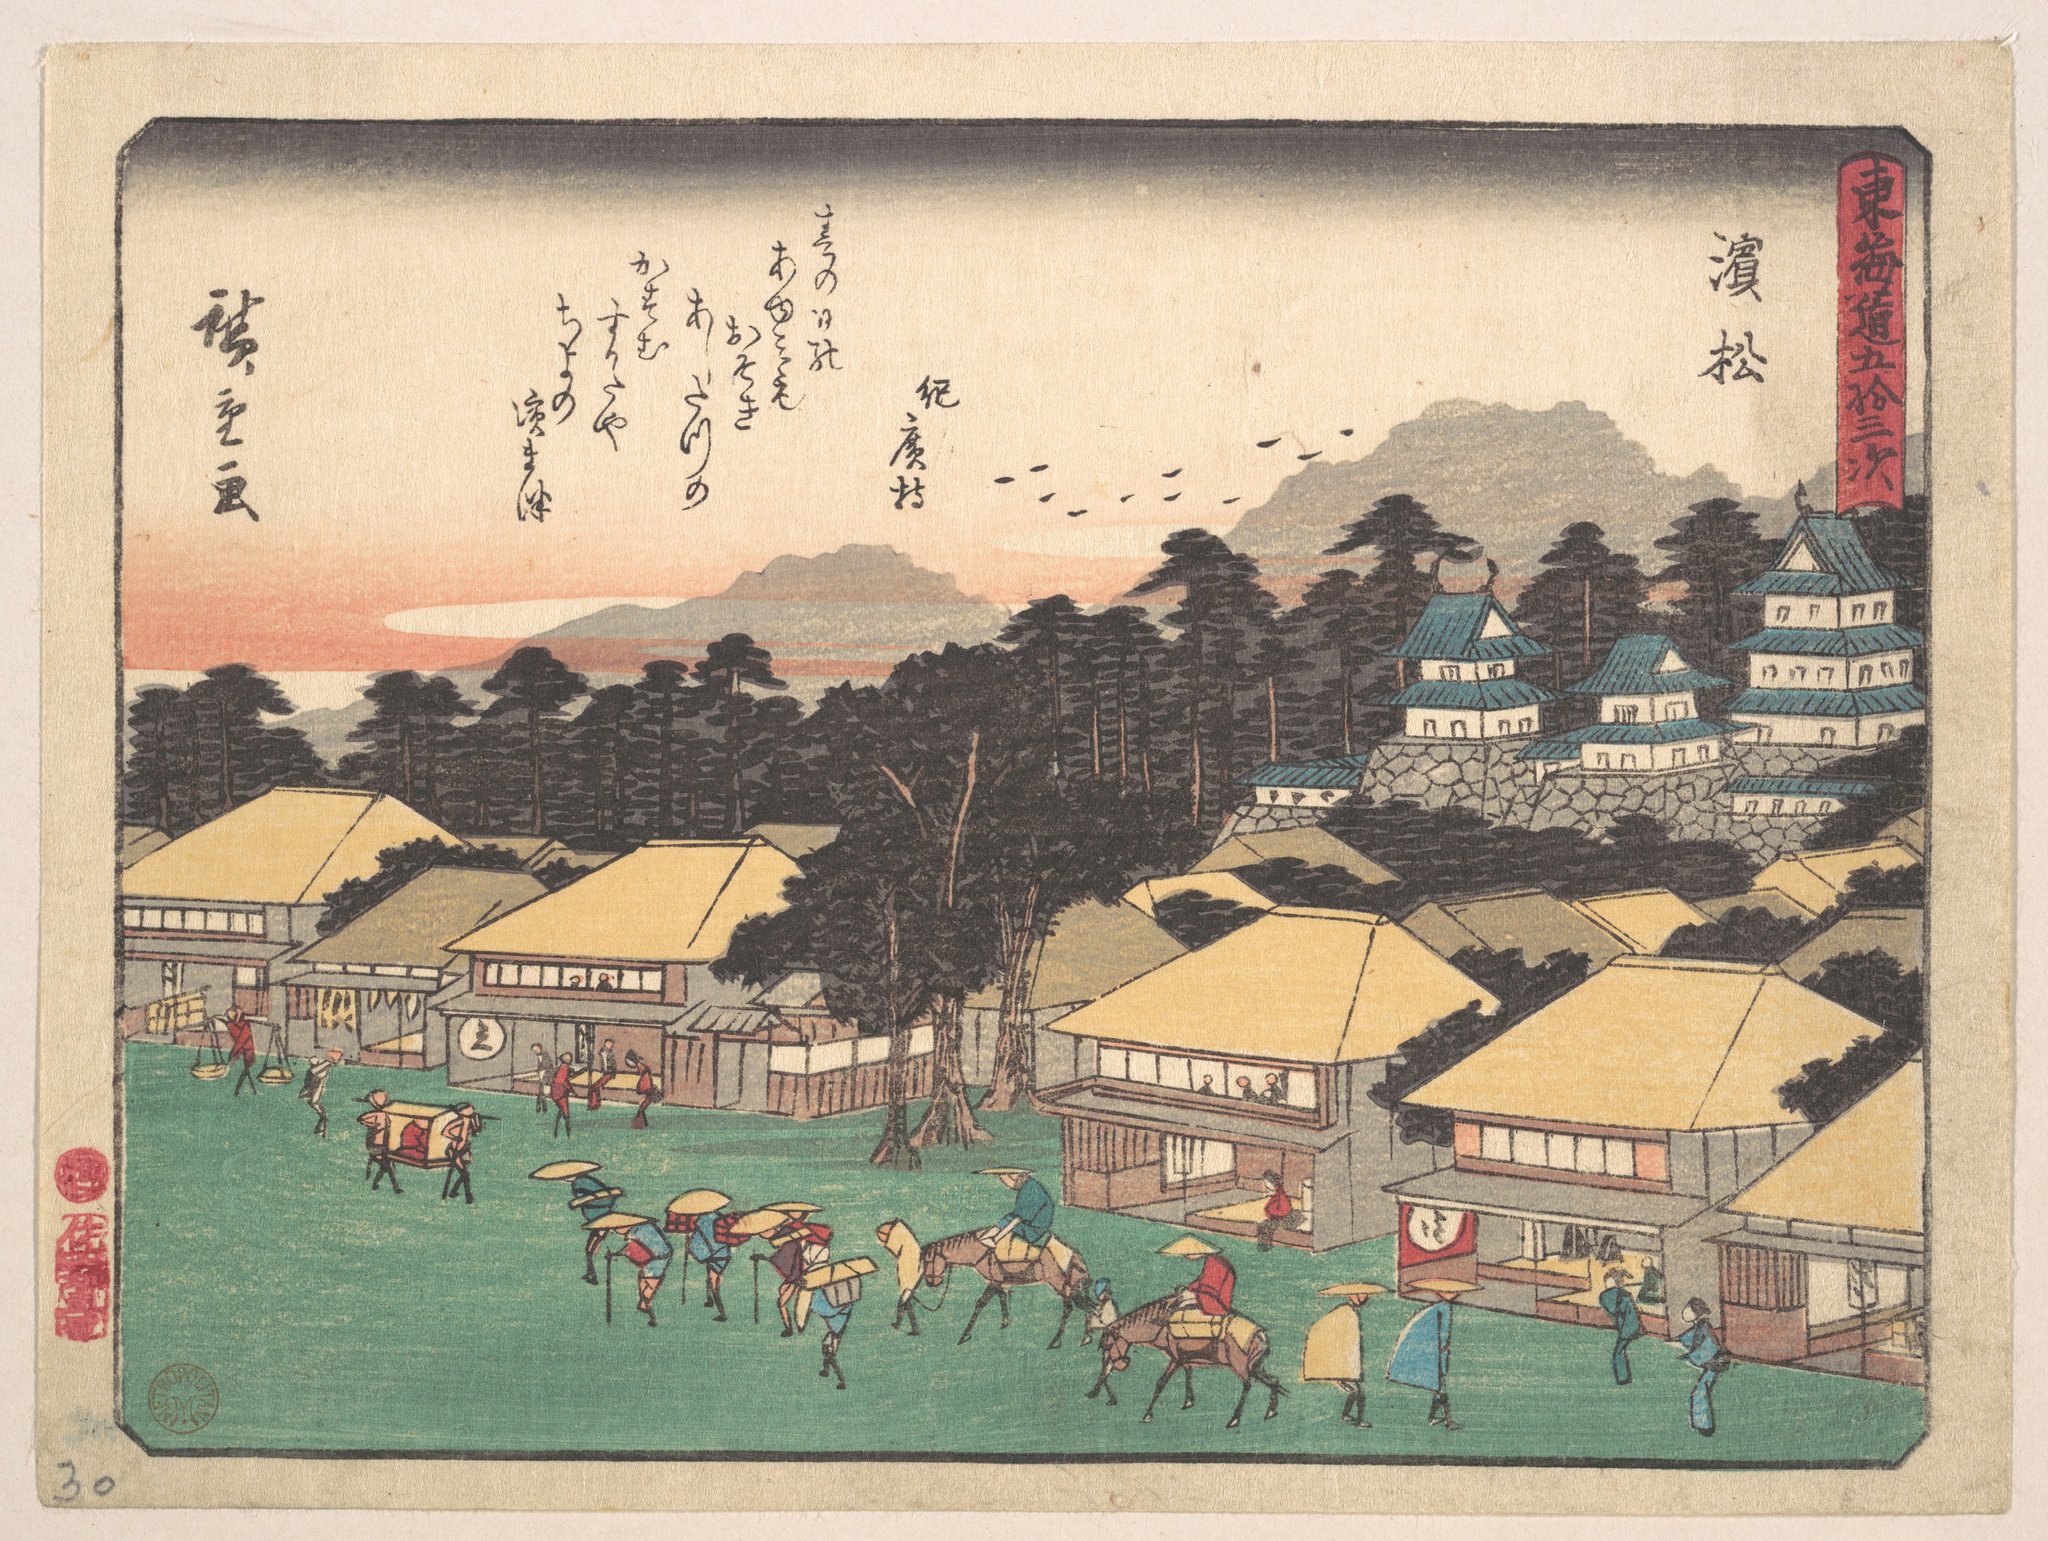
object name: print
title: Hamamatsu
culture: japanese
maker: utagawa hiroshige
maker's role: artist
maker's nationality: japanese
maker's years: 1797-1858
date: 1838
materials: ink, paper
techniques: woodblock print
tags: human figures,houses,horses,trees